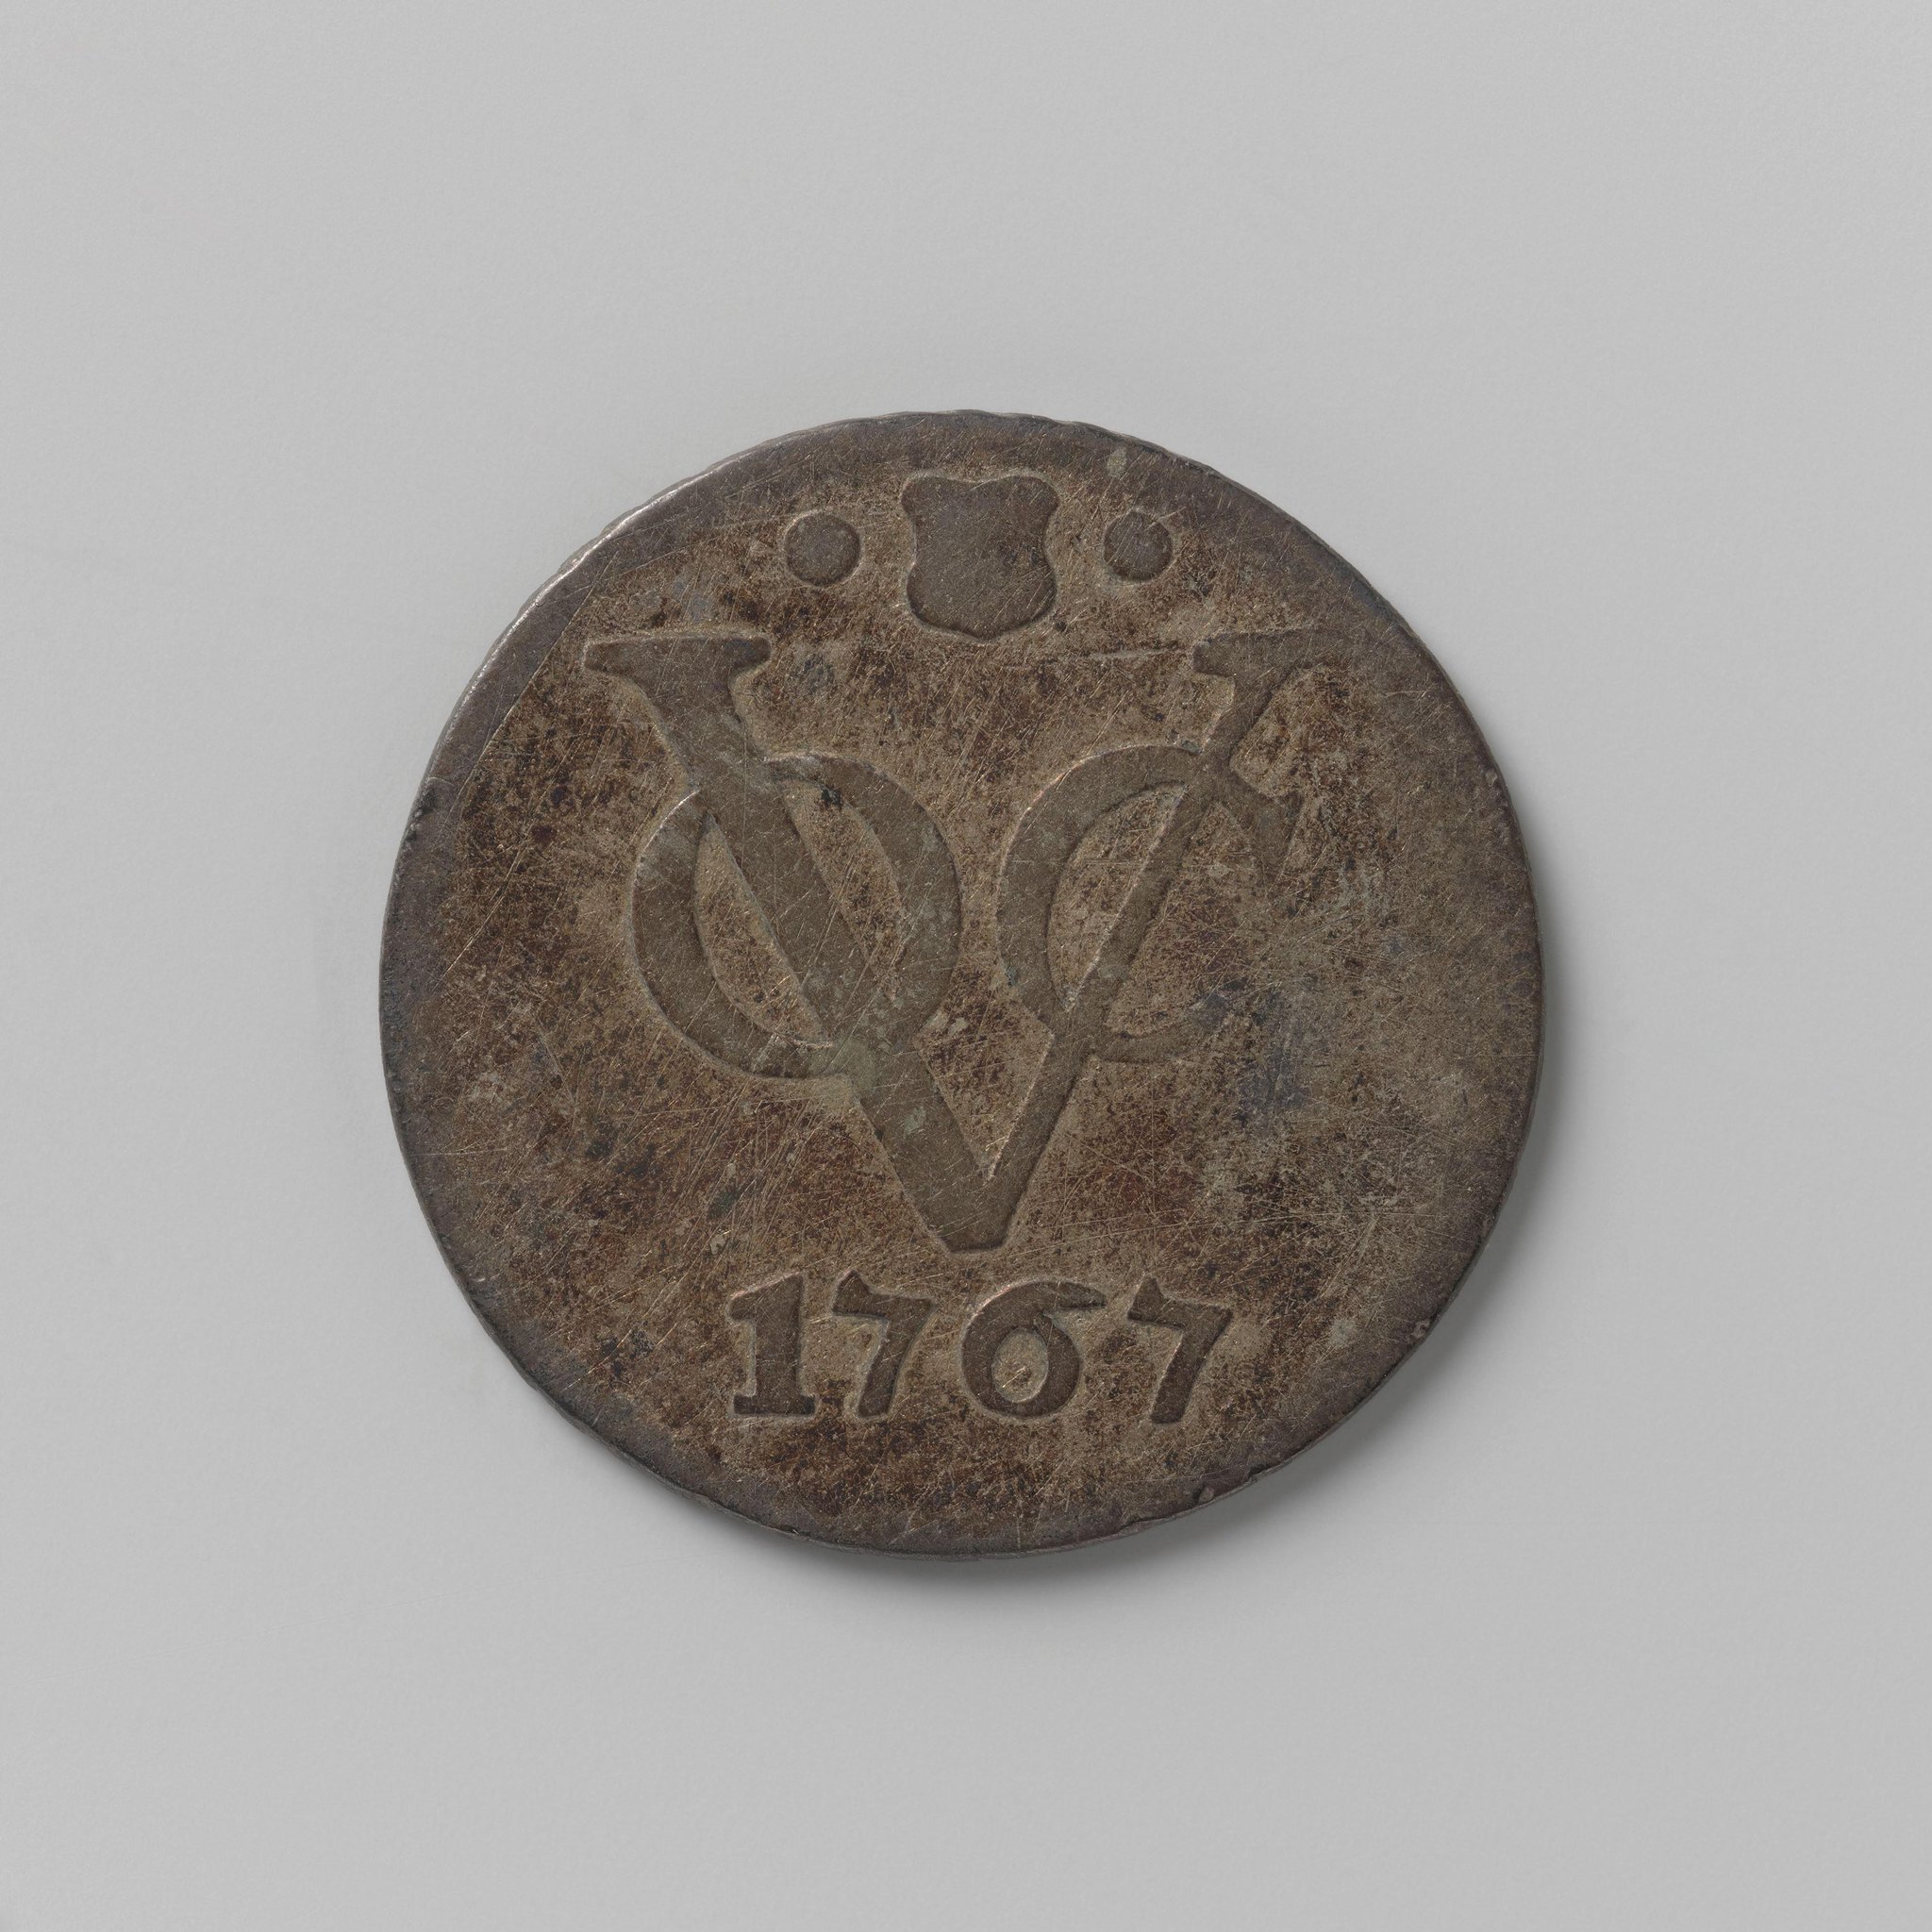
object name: coin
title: VOC, ½ duit stad Utrecht,1767. Afslag in zilver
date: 1767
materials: silver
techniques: striking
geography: utrecht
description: Zilveren munt. Voorzijde: gekroond ingebogen wapenschild van de stad Utrecht. Keerzijde: monogram van de VOC, waarboven muntteken en waaronder jaartal. Kabelrand.